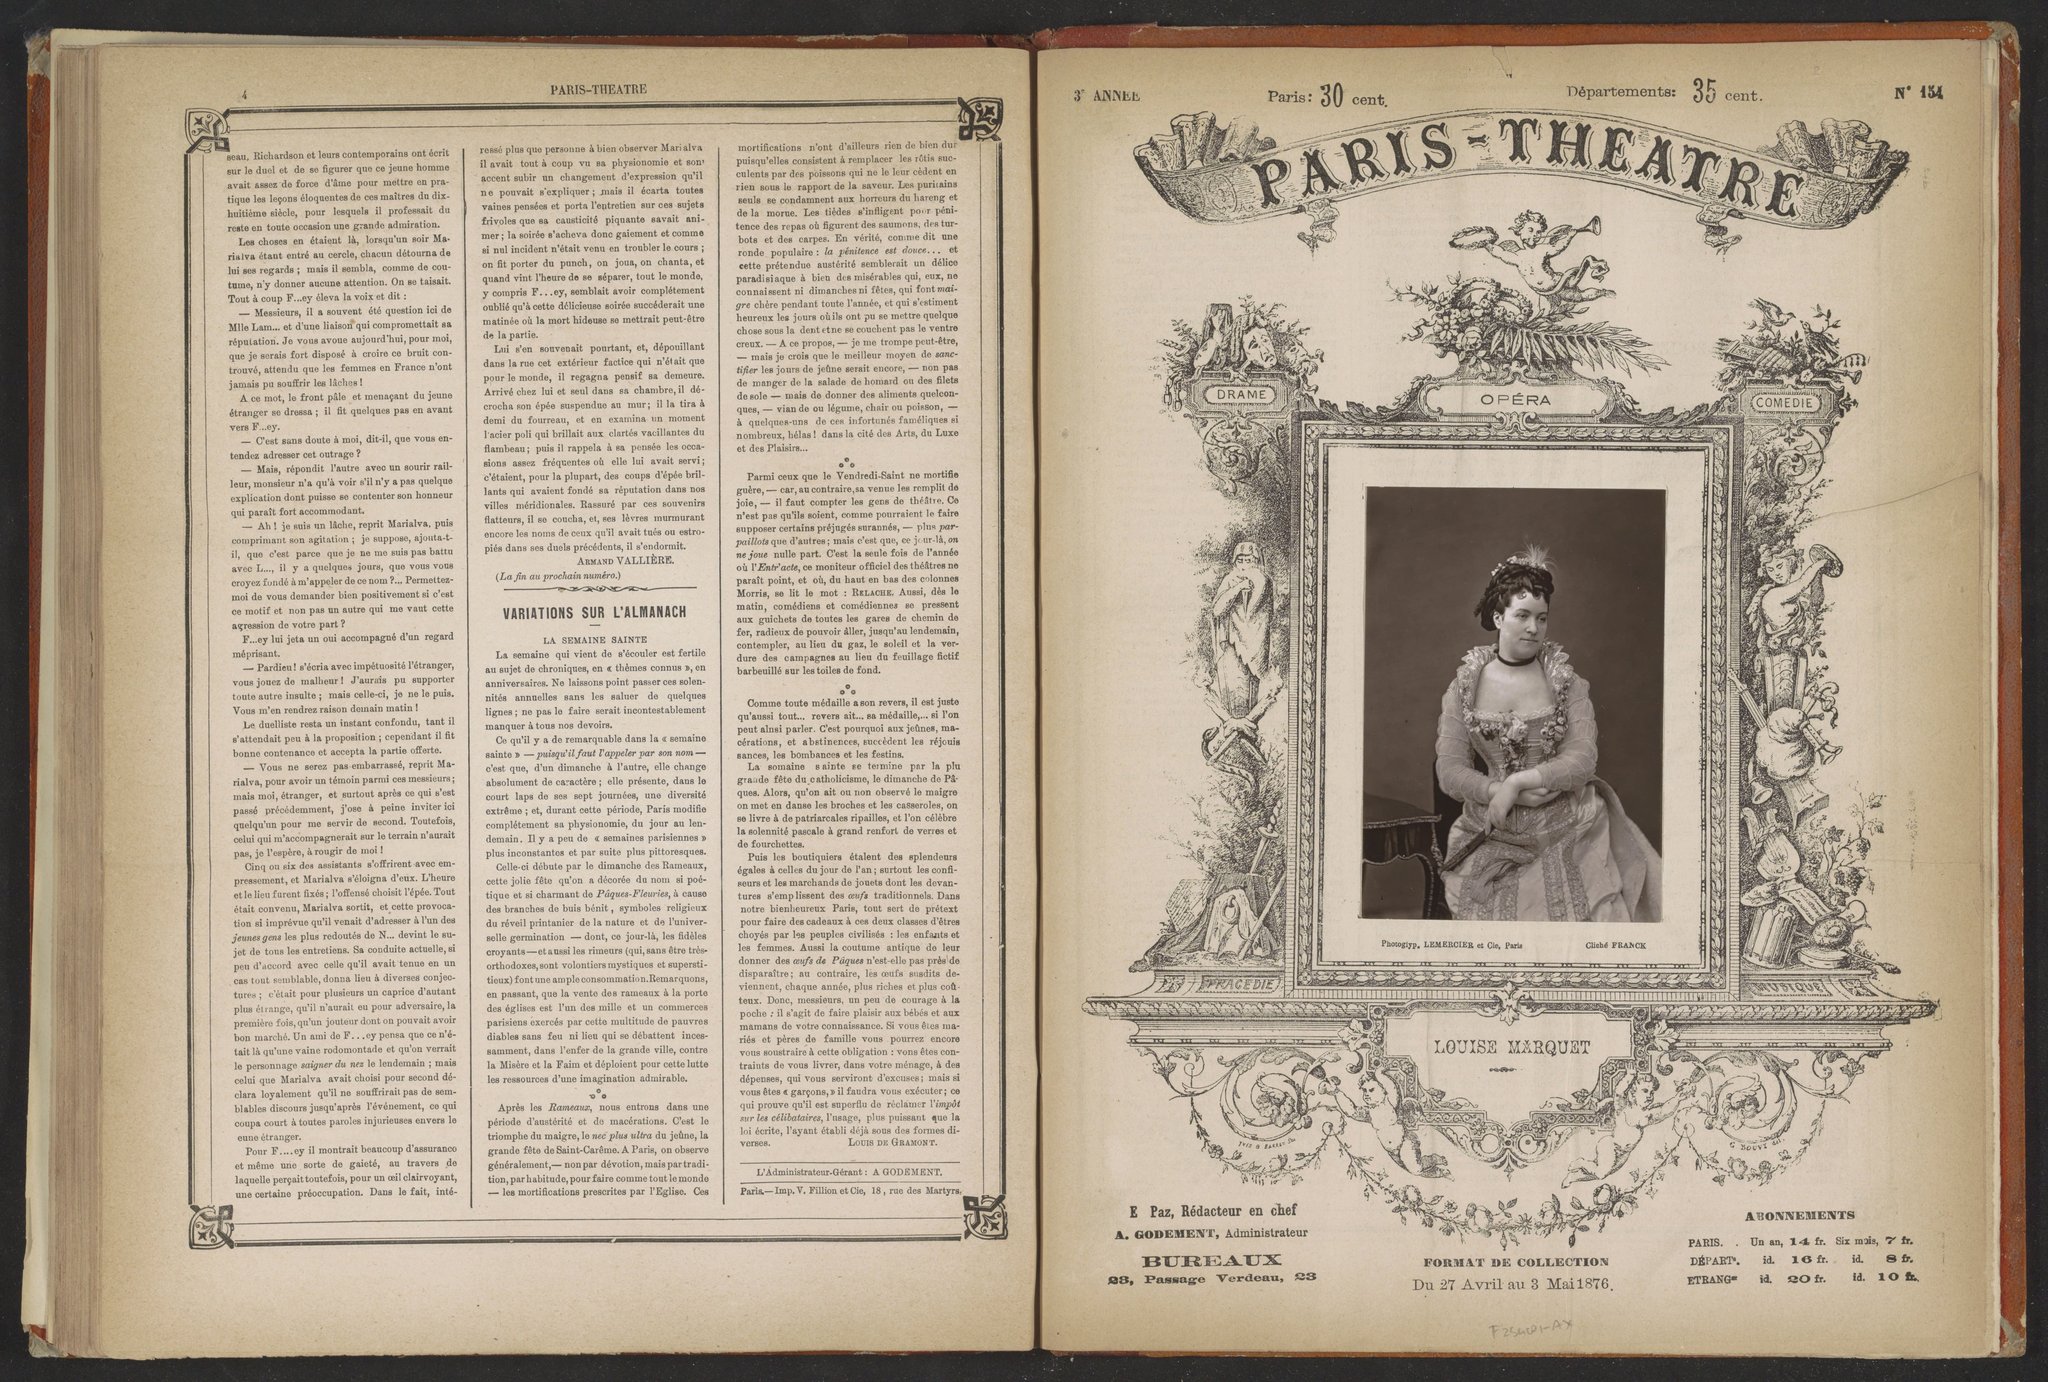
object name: photomechanical print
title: Portret van Louise Marquet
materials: paper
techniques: woodburytype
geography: france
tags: portrait of dancer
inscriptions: number: ‘No 154’, inscription: ‘Du 27 Avril au 3 Mai 1876.’